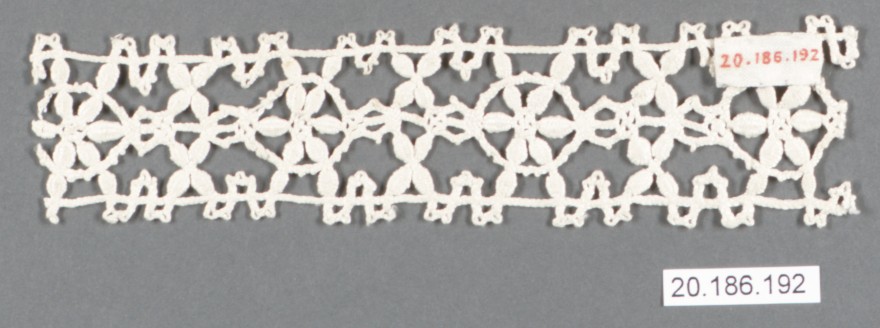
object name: insertion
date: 1601-1700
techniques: lace